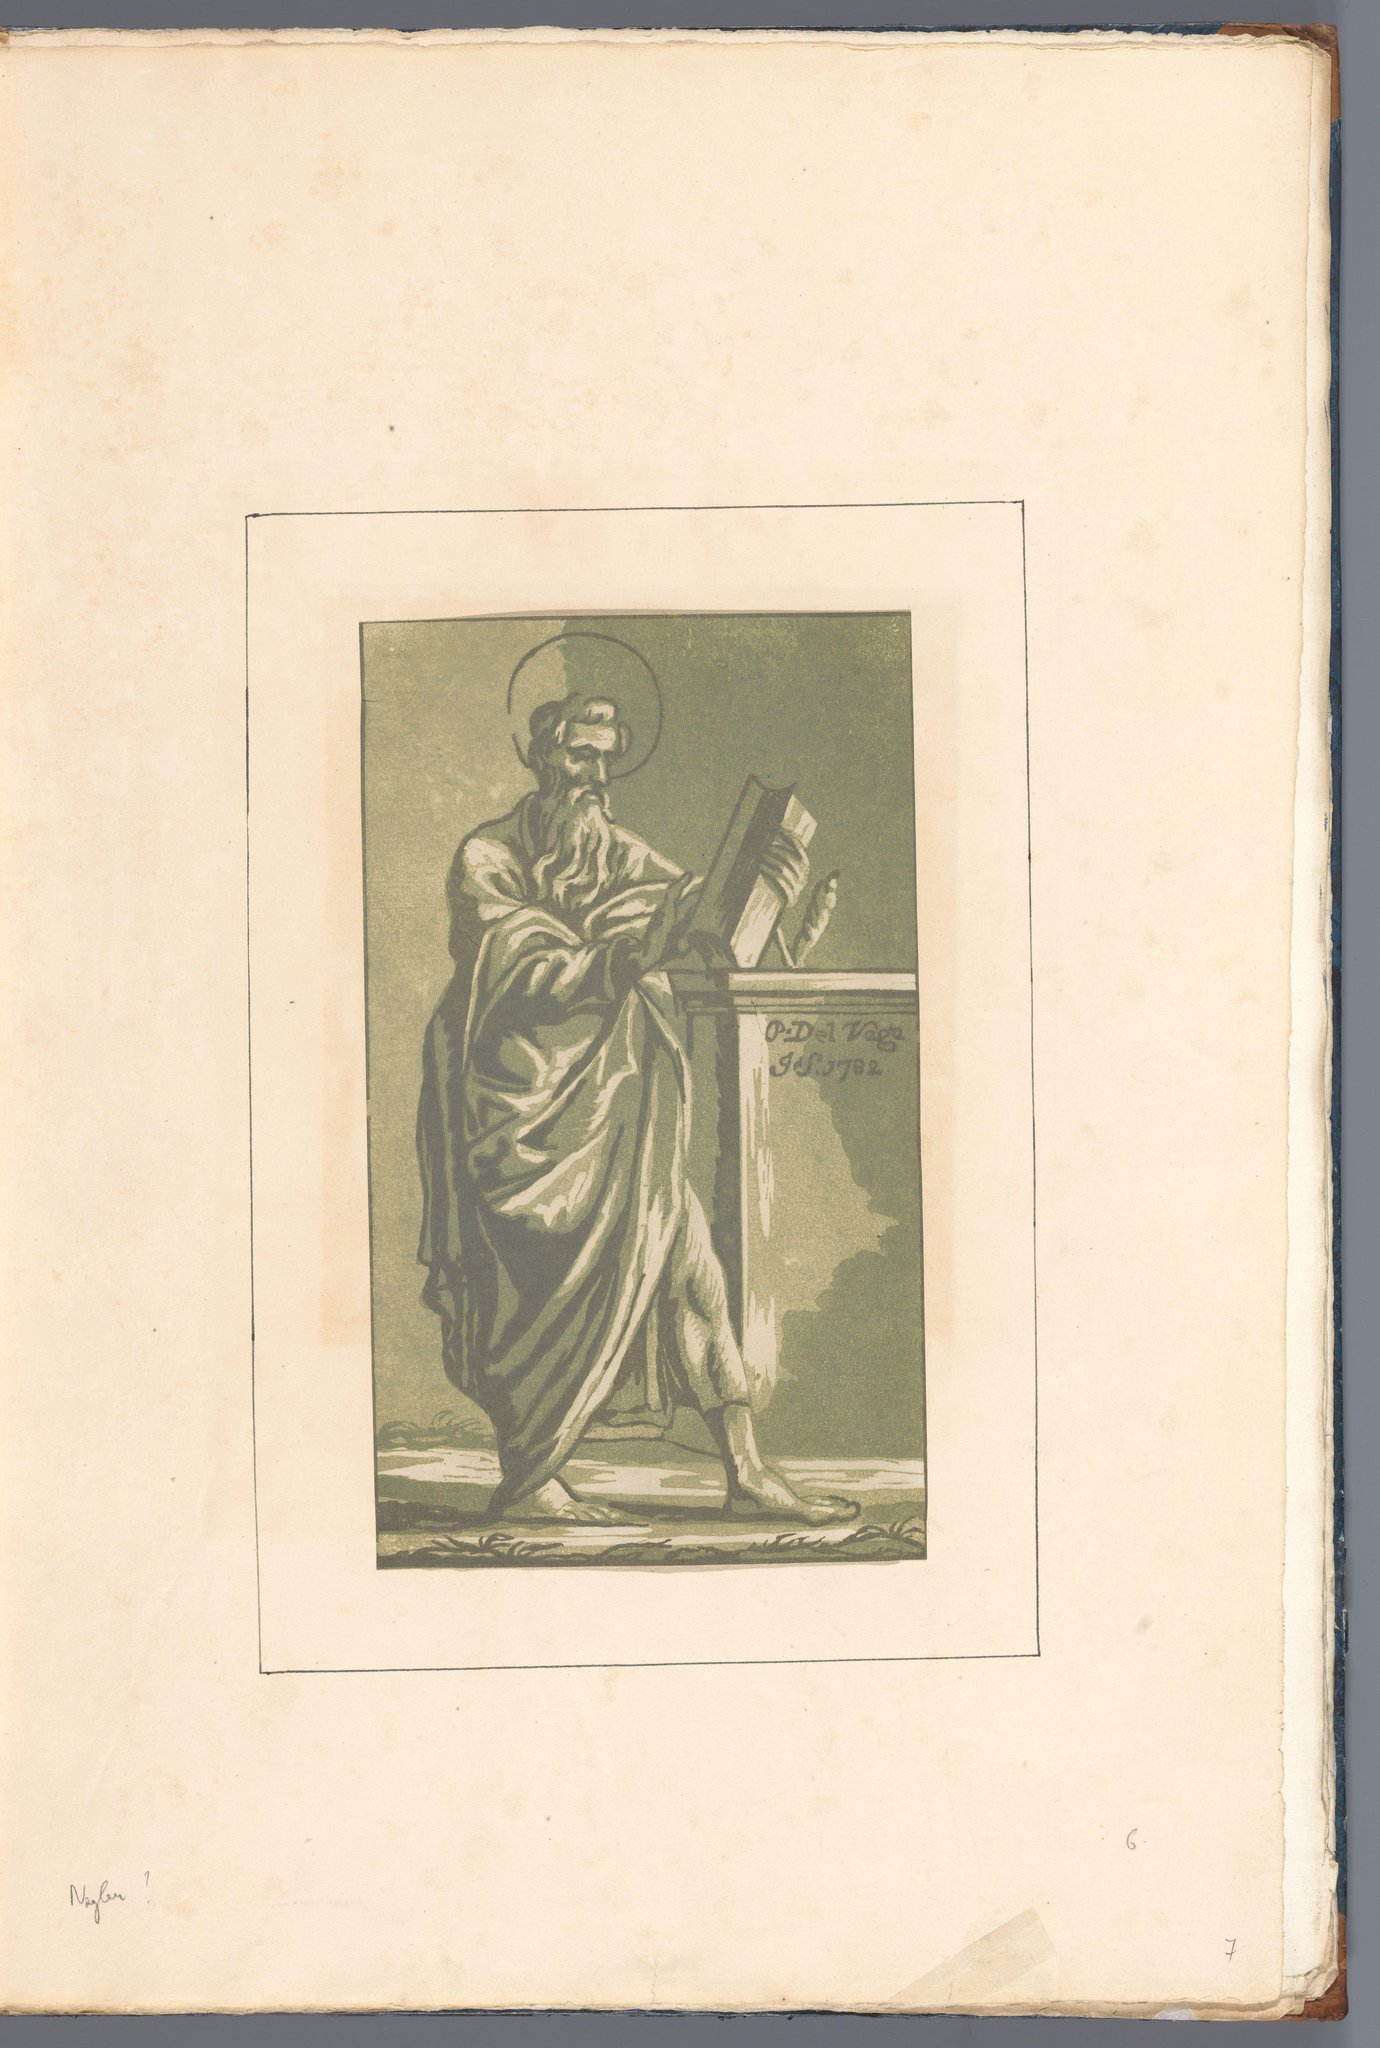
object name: print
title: Apostel Petrus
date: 1782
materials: ink, paper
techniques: woodcut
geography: england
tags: the apostle peter, first bishop of rome; possible attributes: book, cock, (upturned) cross, (triple) crozier, fish, key, scroll, ship, tiara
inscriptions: date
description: Staande heilige met boek, waarschijnlijk de apostel Petrus. Onderdeel van een album met 26 ingeplakte clair-obscur houtsneden naar Italiaanse kunstenaars uit de zestiende eeuw.